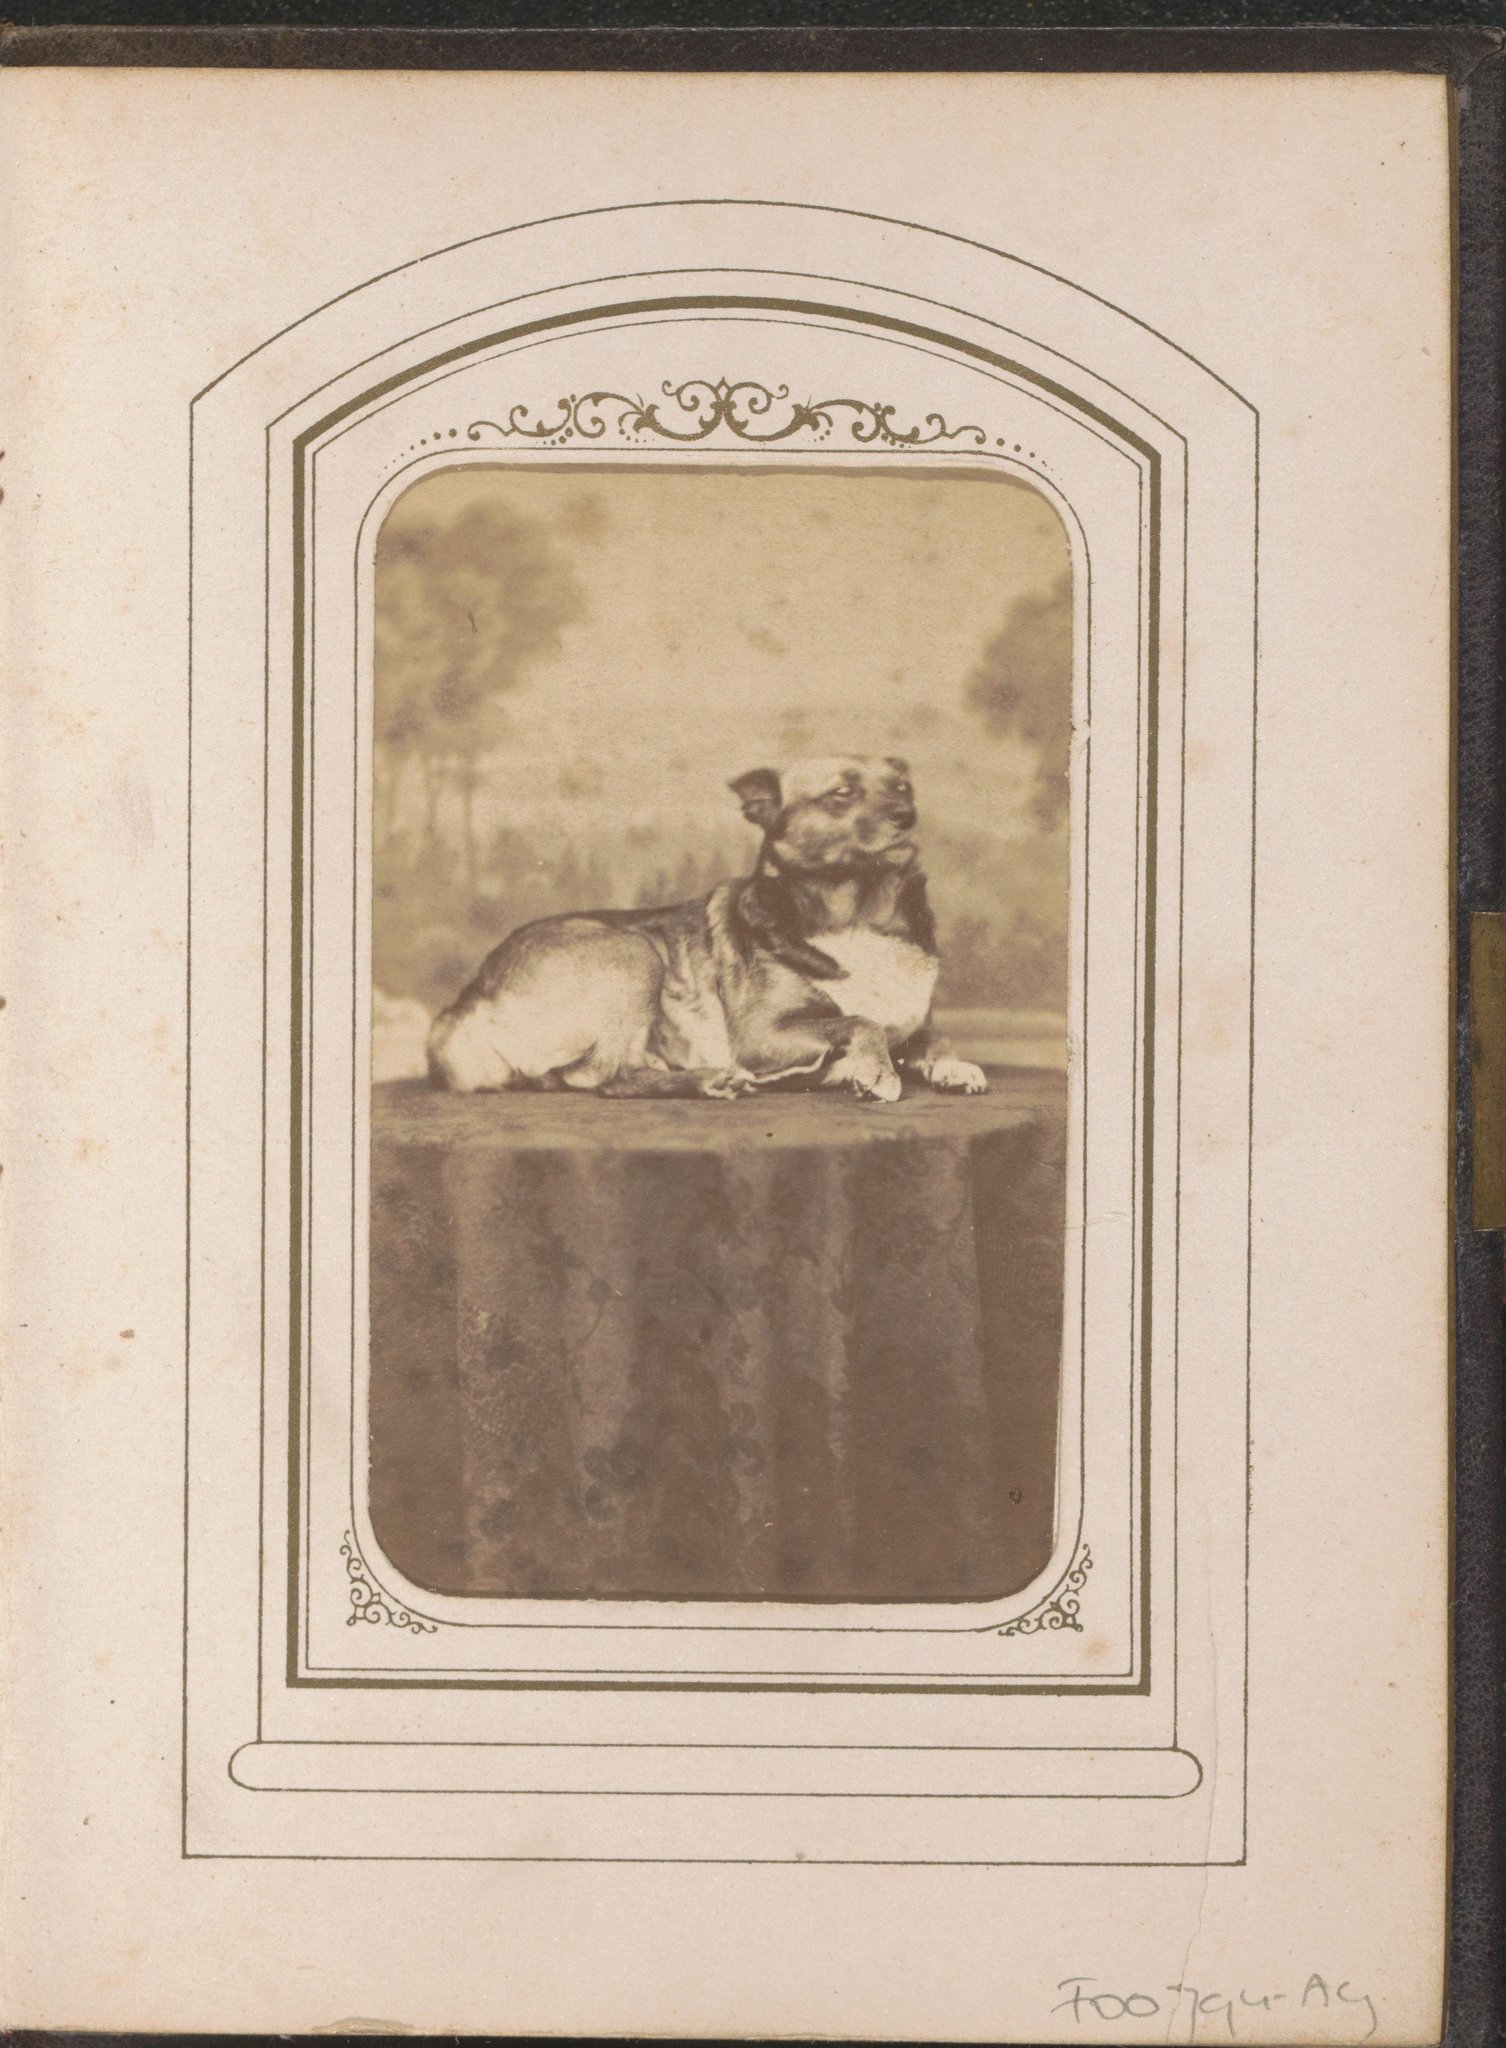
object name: photograph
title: Liggende hond genaamd Bello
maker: l.j. goudman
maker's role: fotograaf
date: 1860-1890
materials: cardboard, paper, photographic support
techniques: albumen print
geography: amsterdam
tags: dog, amsterdam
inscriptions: inscription: ‘Bello’, address: ‘Lange Leidsche straat No. 350 Amsterdam’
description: Onderdeel van Fotoalbum met 36 opnames van Europese landen.